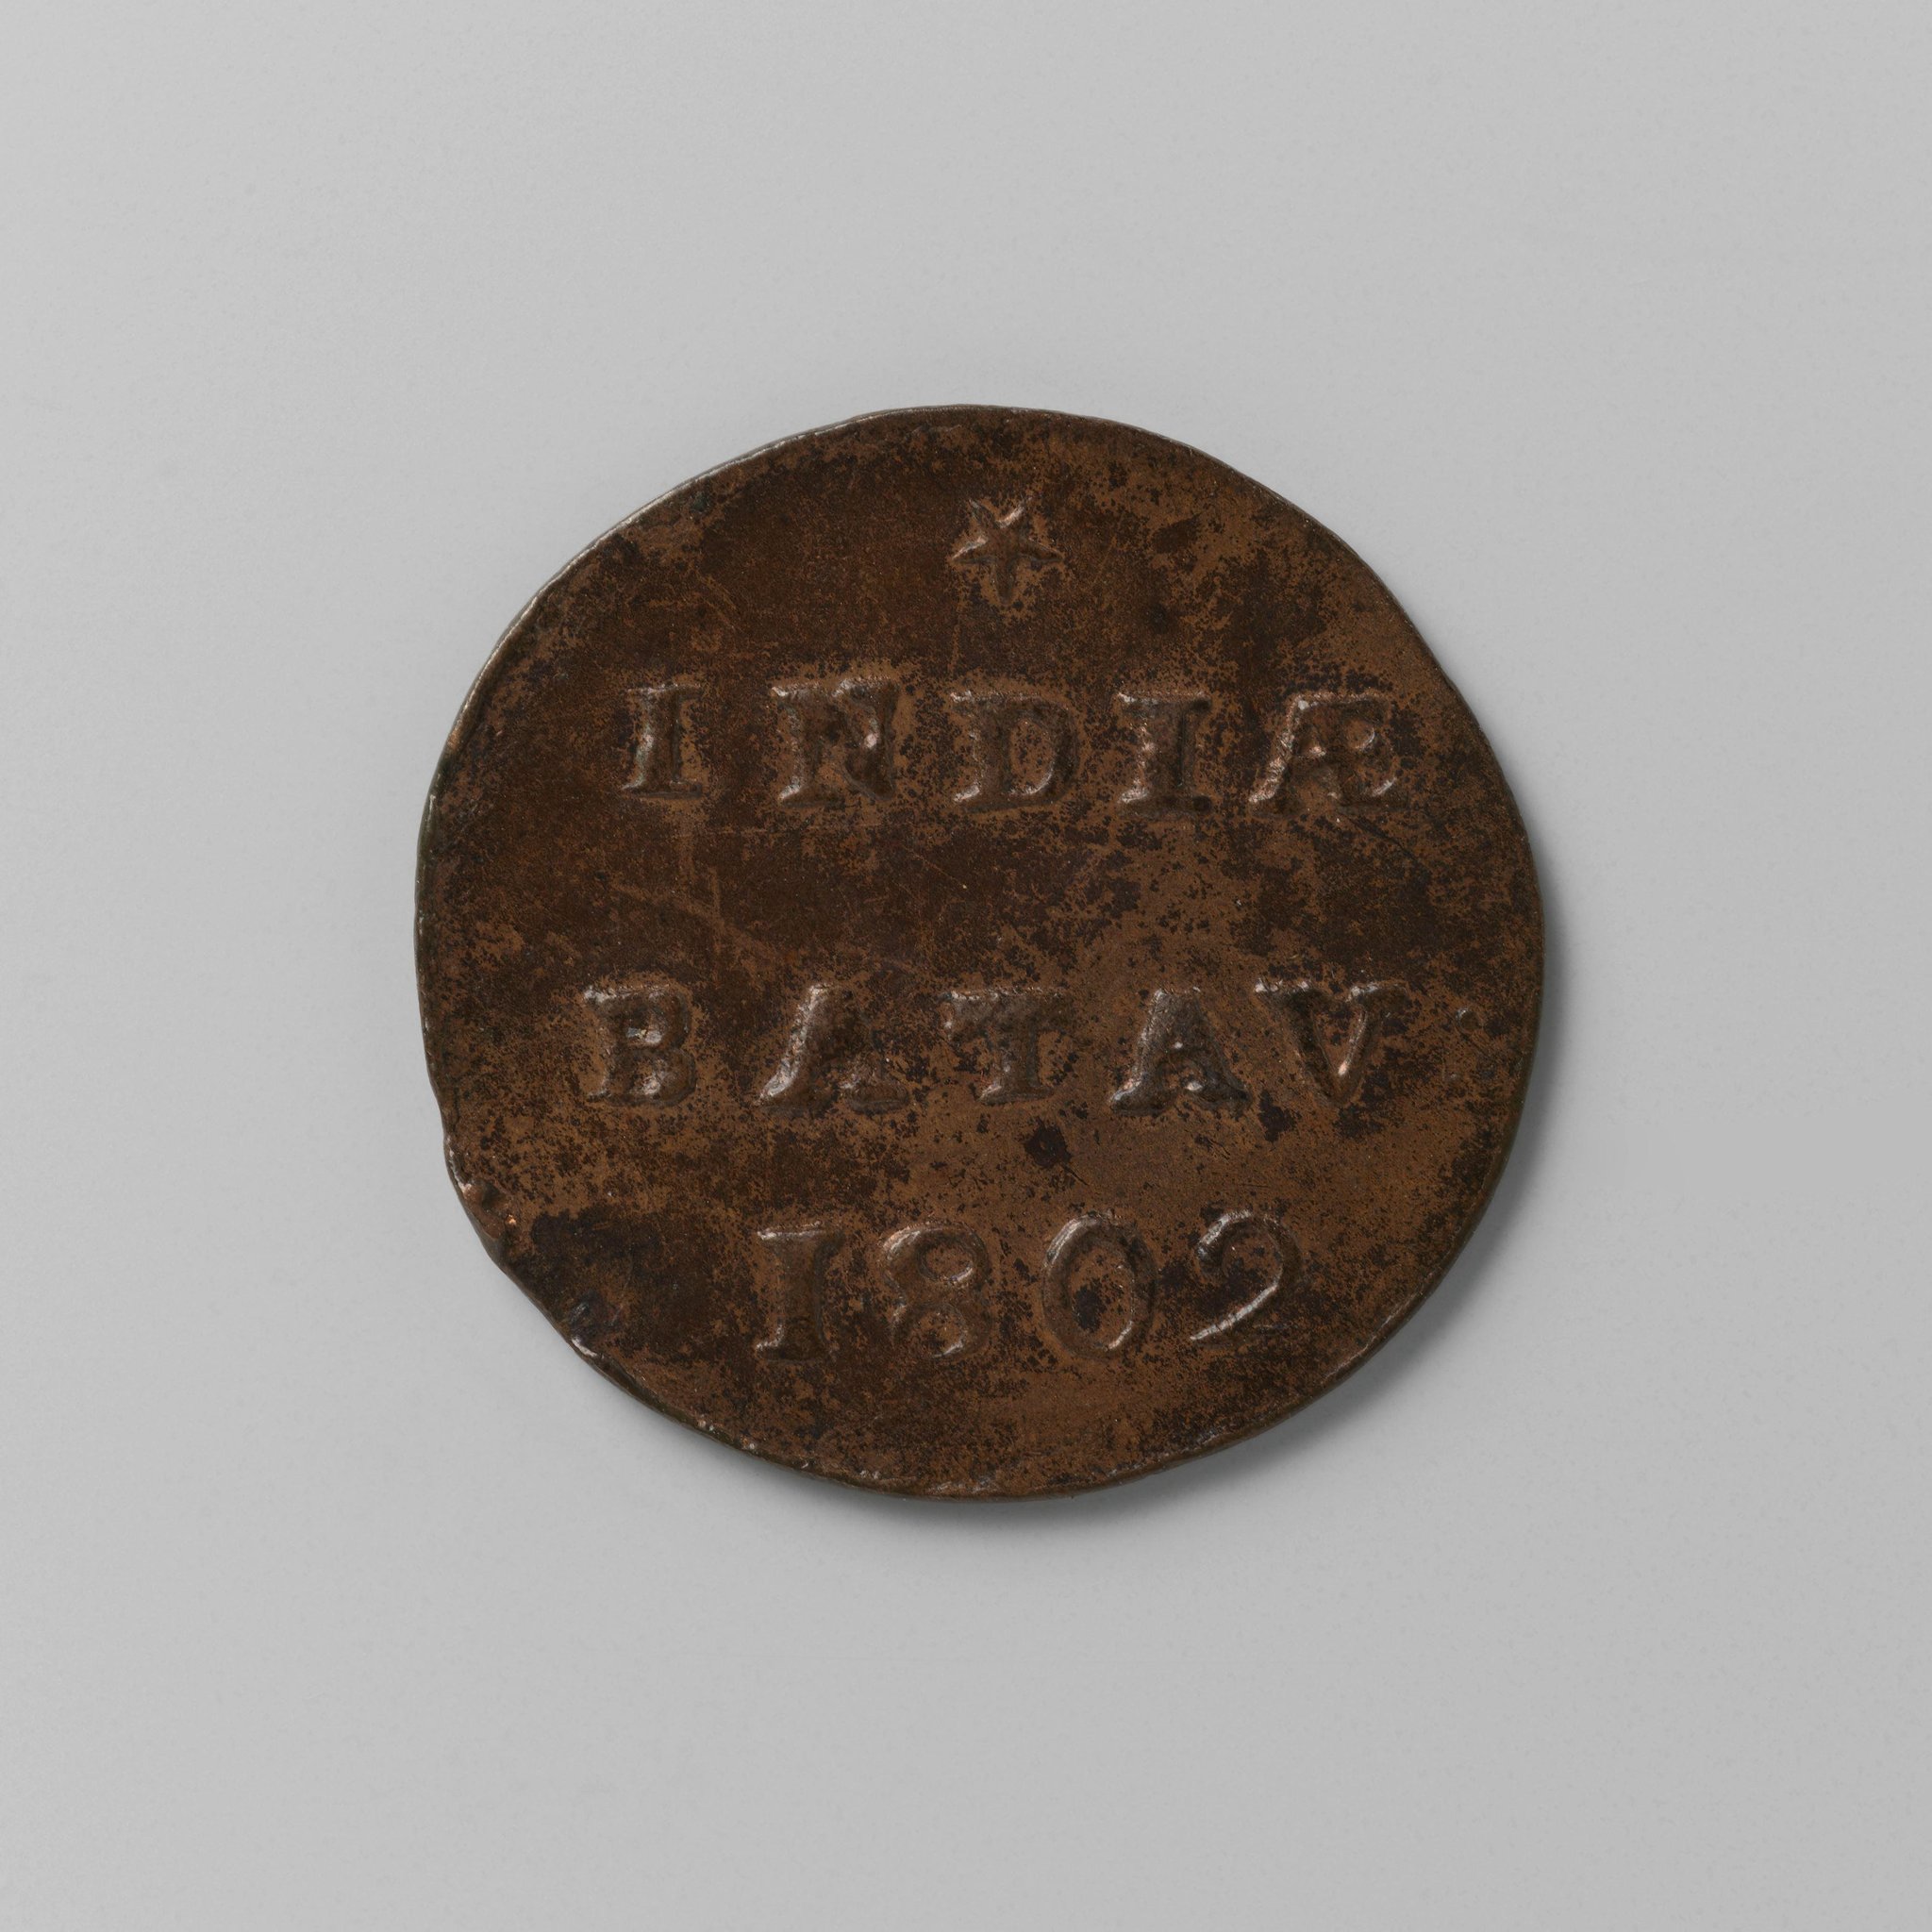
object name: coin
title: Nederlands Indië, ½ duit Holland, 1802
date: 1802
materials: copper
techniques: striking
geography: enkhuizen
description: Koperen munt. Voorzijde: tweeregelig opschrift, waarboven muntteken en waaronder jaartal. Keerzijde: tussen waarde-aanduiding 5 1/32 G gekroond generaliteitswapenschild. Gladde rand.